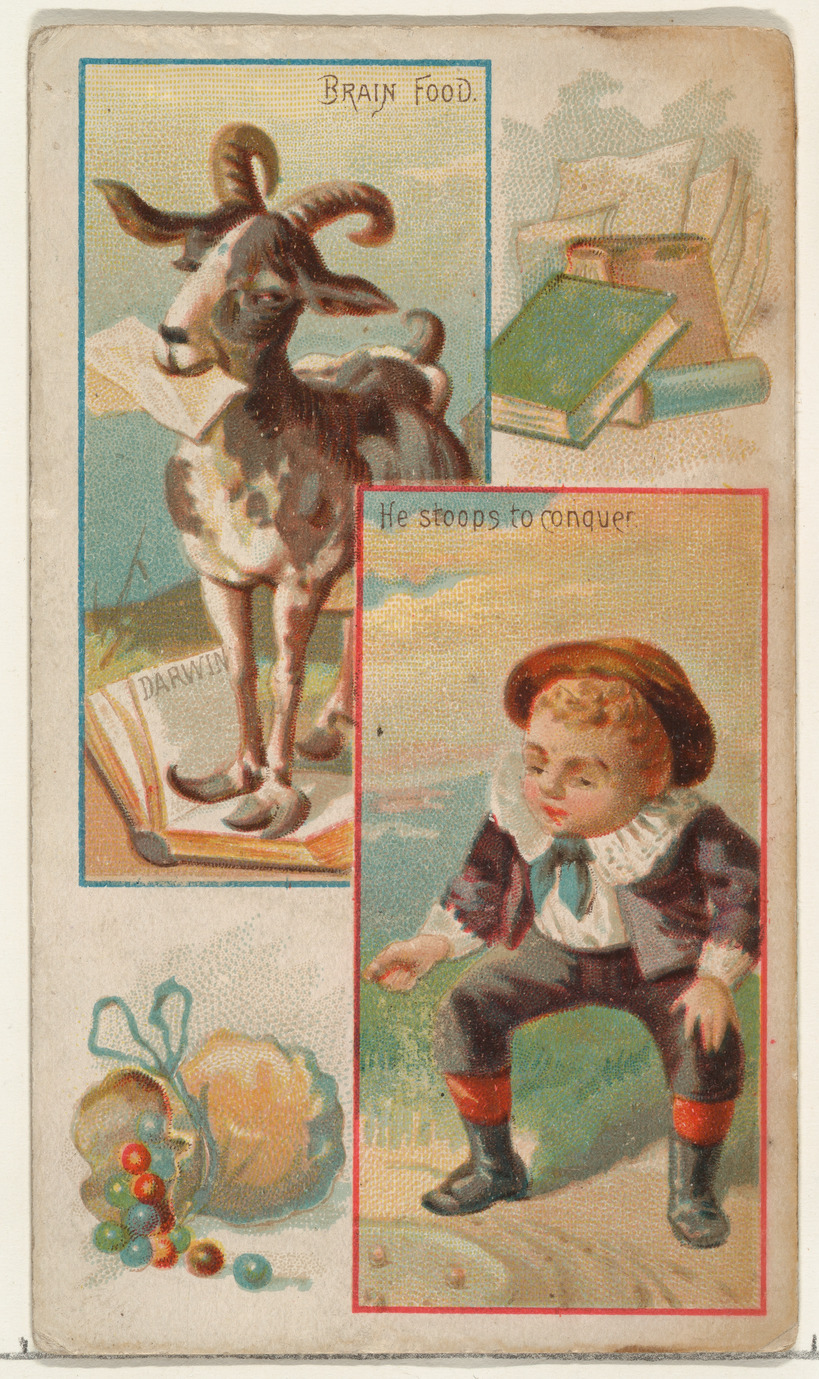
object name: print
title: Brain Food / He Stoops to Conquer, from the Jokes series (N118) issued by Duke Sons & Co. to promote Honest Long Cut Tobacco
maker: w. duke, sons & co.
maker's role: publisher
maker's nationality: american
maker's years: 1870-1920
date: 1891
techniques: color lithograph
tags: boys,rams